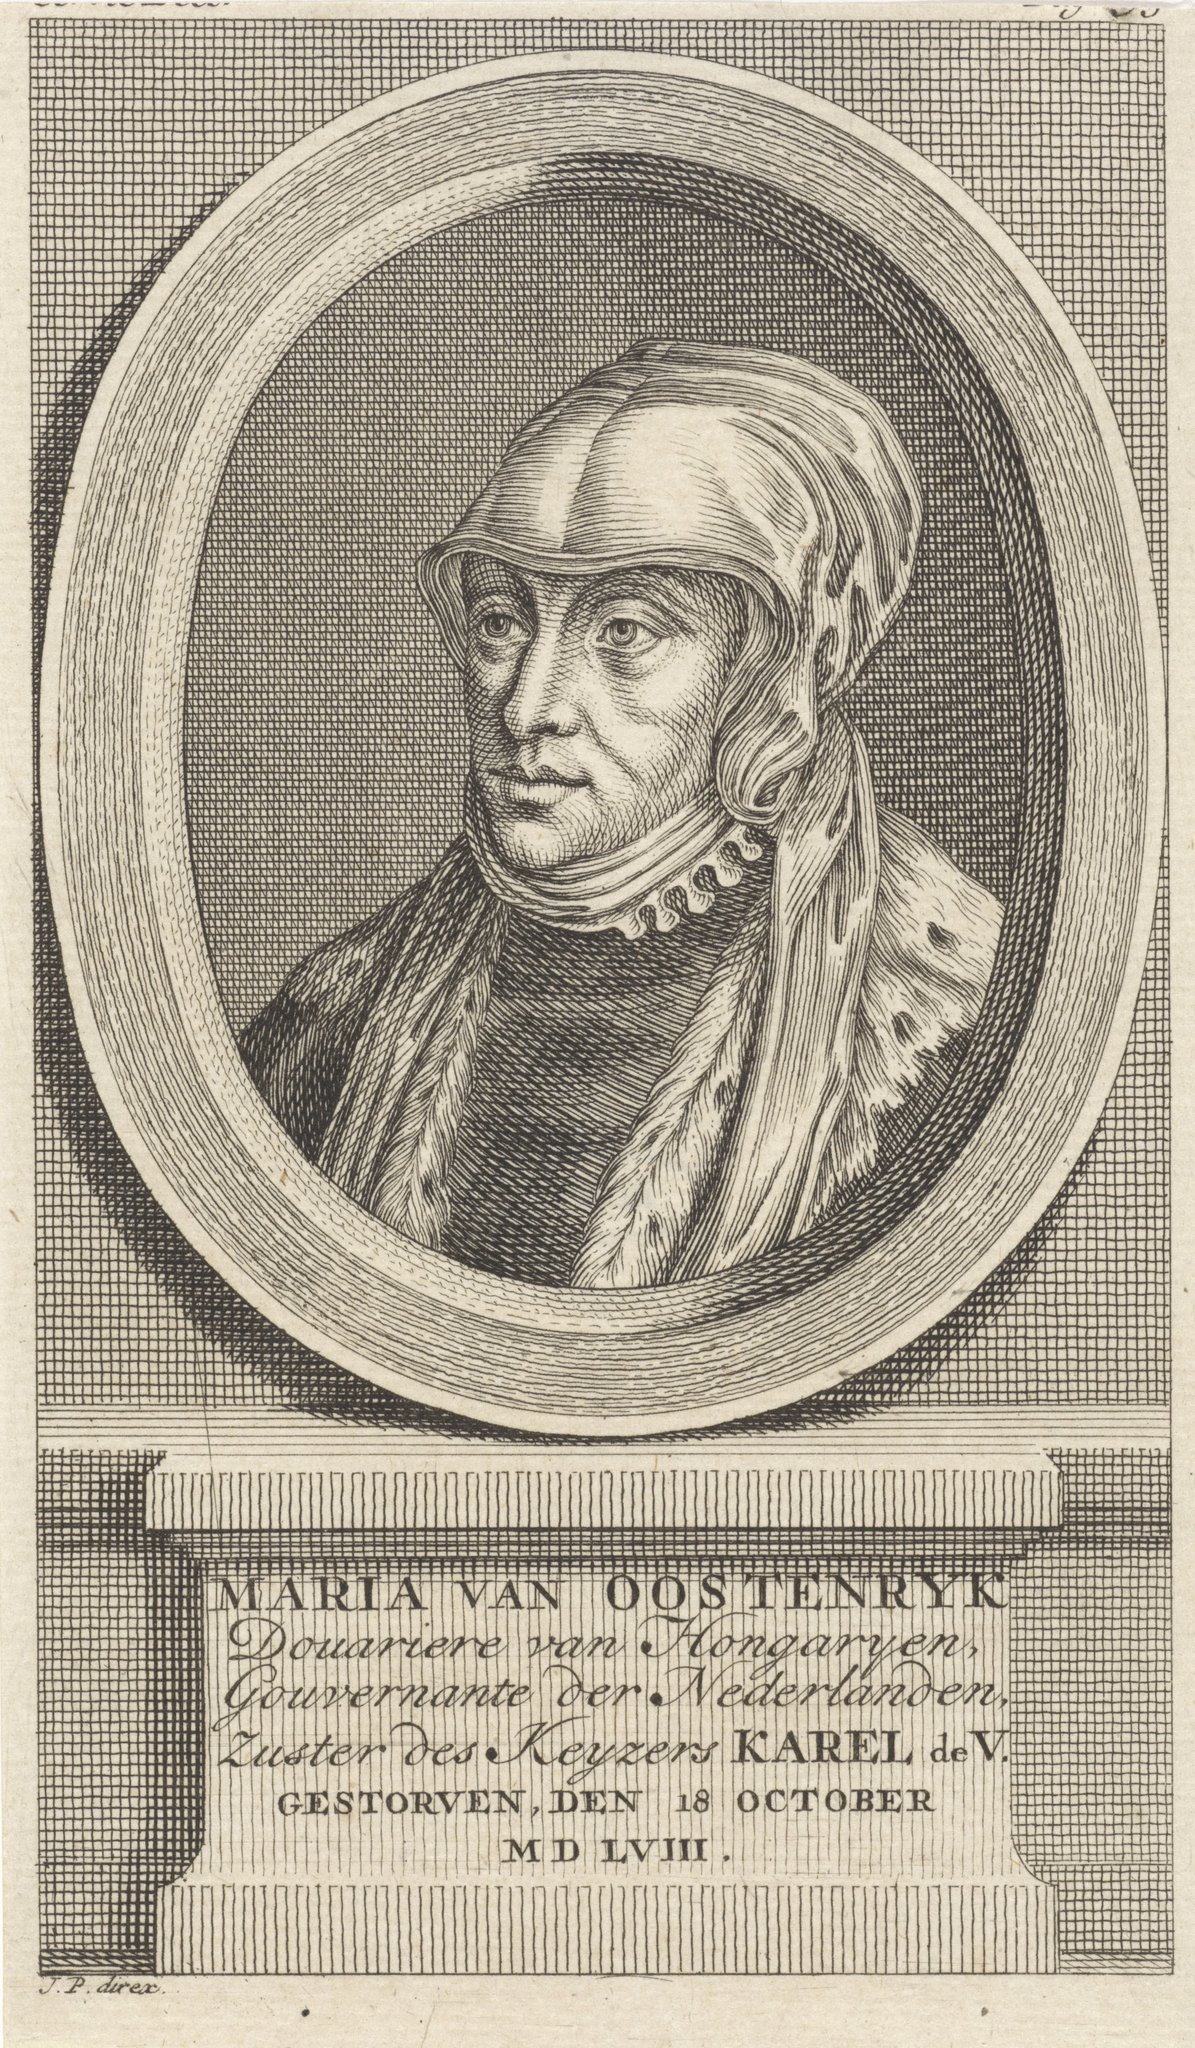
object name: book illustration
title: Portret van Maria van Hongarije, landvoogdes der Nederlanden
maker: jan punt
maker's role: draughtsman, print maker, publisher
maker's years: 1711-1779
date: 1748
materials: paper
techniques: engraving, etching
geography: northern netherlands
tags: maria van hongarije (landvoogdes der nederlanden)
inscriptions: collector's mark: Lugt 2228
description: Illustratie uit: Meteren, Emanuel van. Historie van de oorlogen en geschiedenissen der Nederlanderen, en der zelver naburen: beginnende met den jare 1315, en eindigende met den jare 1611, deel I, p. 95. Gorinchem: weduwe Nicolaas Goetzee, 1748.